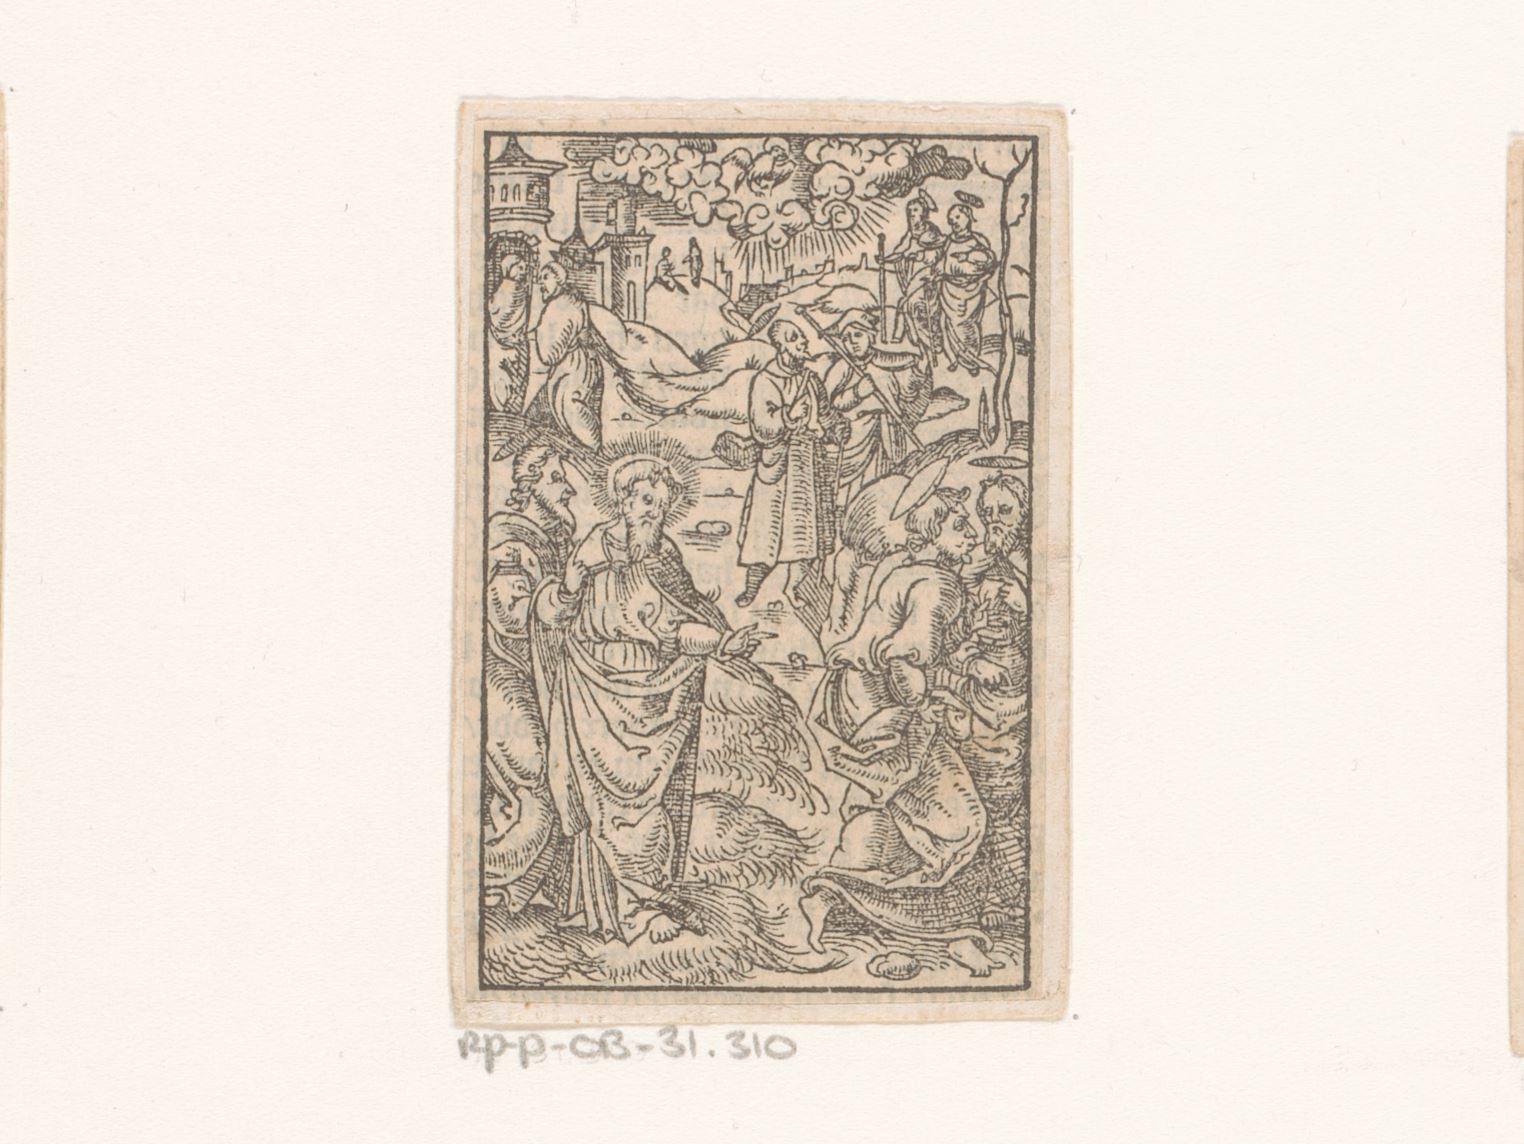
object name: print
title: Uitzending van de twaalf apostelen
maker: Anonymous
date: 1600-1699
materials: paper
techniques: letterpress printing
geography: netherlands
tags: christ sends apostles out in pairs (matthew 10:1-16; mark 6:7-11; luke 9:1-5)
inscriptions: collector's mark: Lugt 240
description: Landschap met op verschillende plekken apostelen, die in paren op reis zijn om de booschap van Christus te verkondigen.